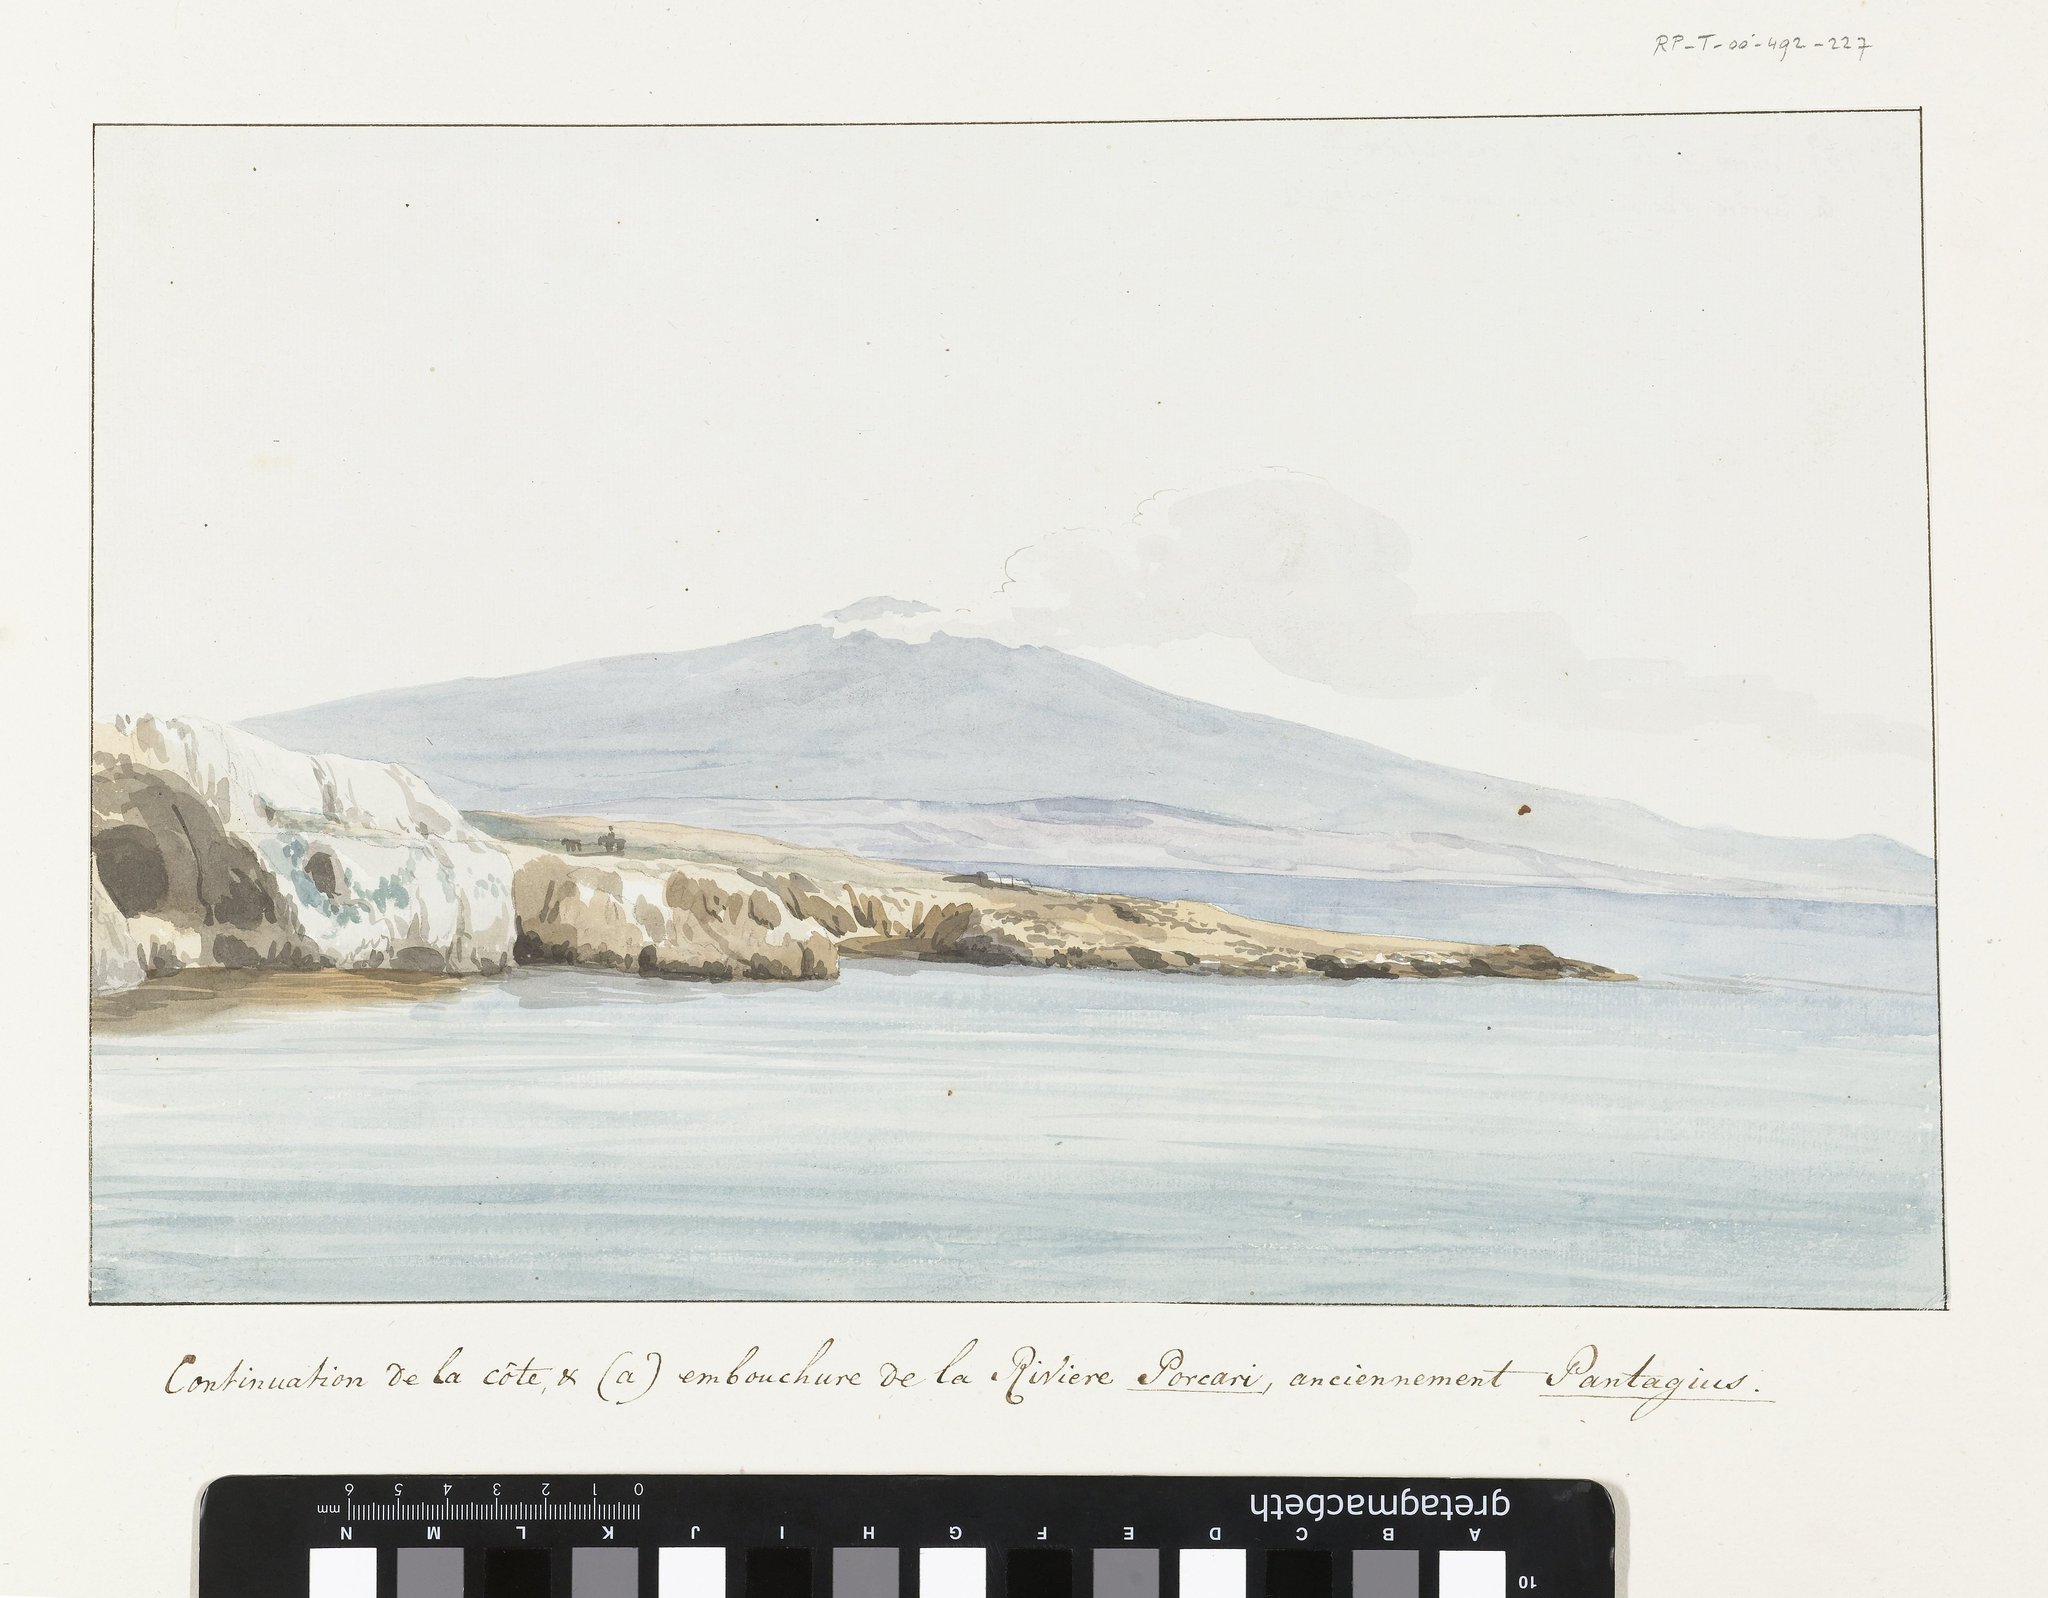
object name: drawing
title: Gezicht op de kust met brede monding van rivier Porcari, voorheen Pantagias genaamd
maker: louis ducros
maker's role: draughtsman, print maker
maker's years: 1748-1810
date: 1778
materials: chalk, paper, watercolor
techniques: brush, pen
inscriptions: number: ‘No 184 Suite de la côte, & embouchûre de la Rivière Porcari, anciennement Pantagius’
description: Tekening uit het album 'Voyage en Italie, en Sicile et à Malte', 1778.